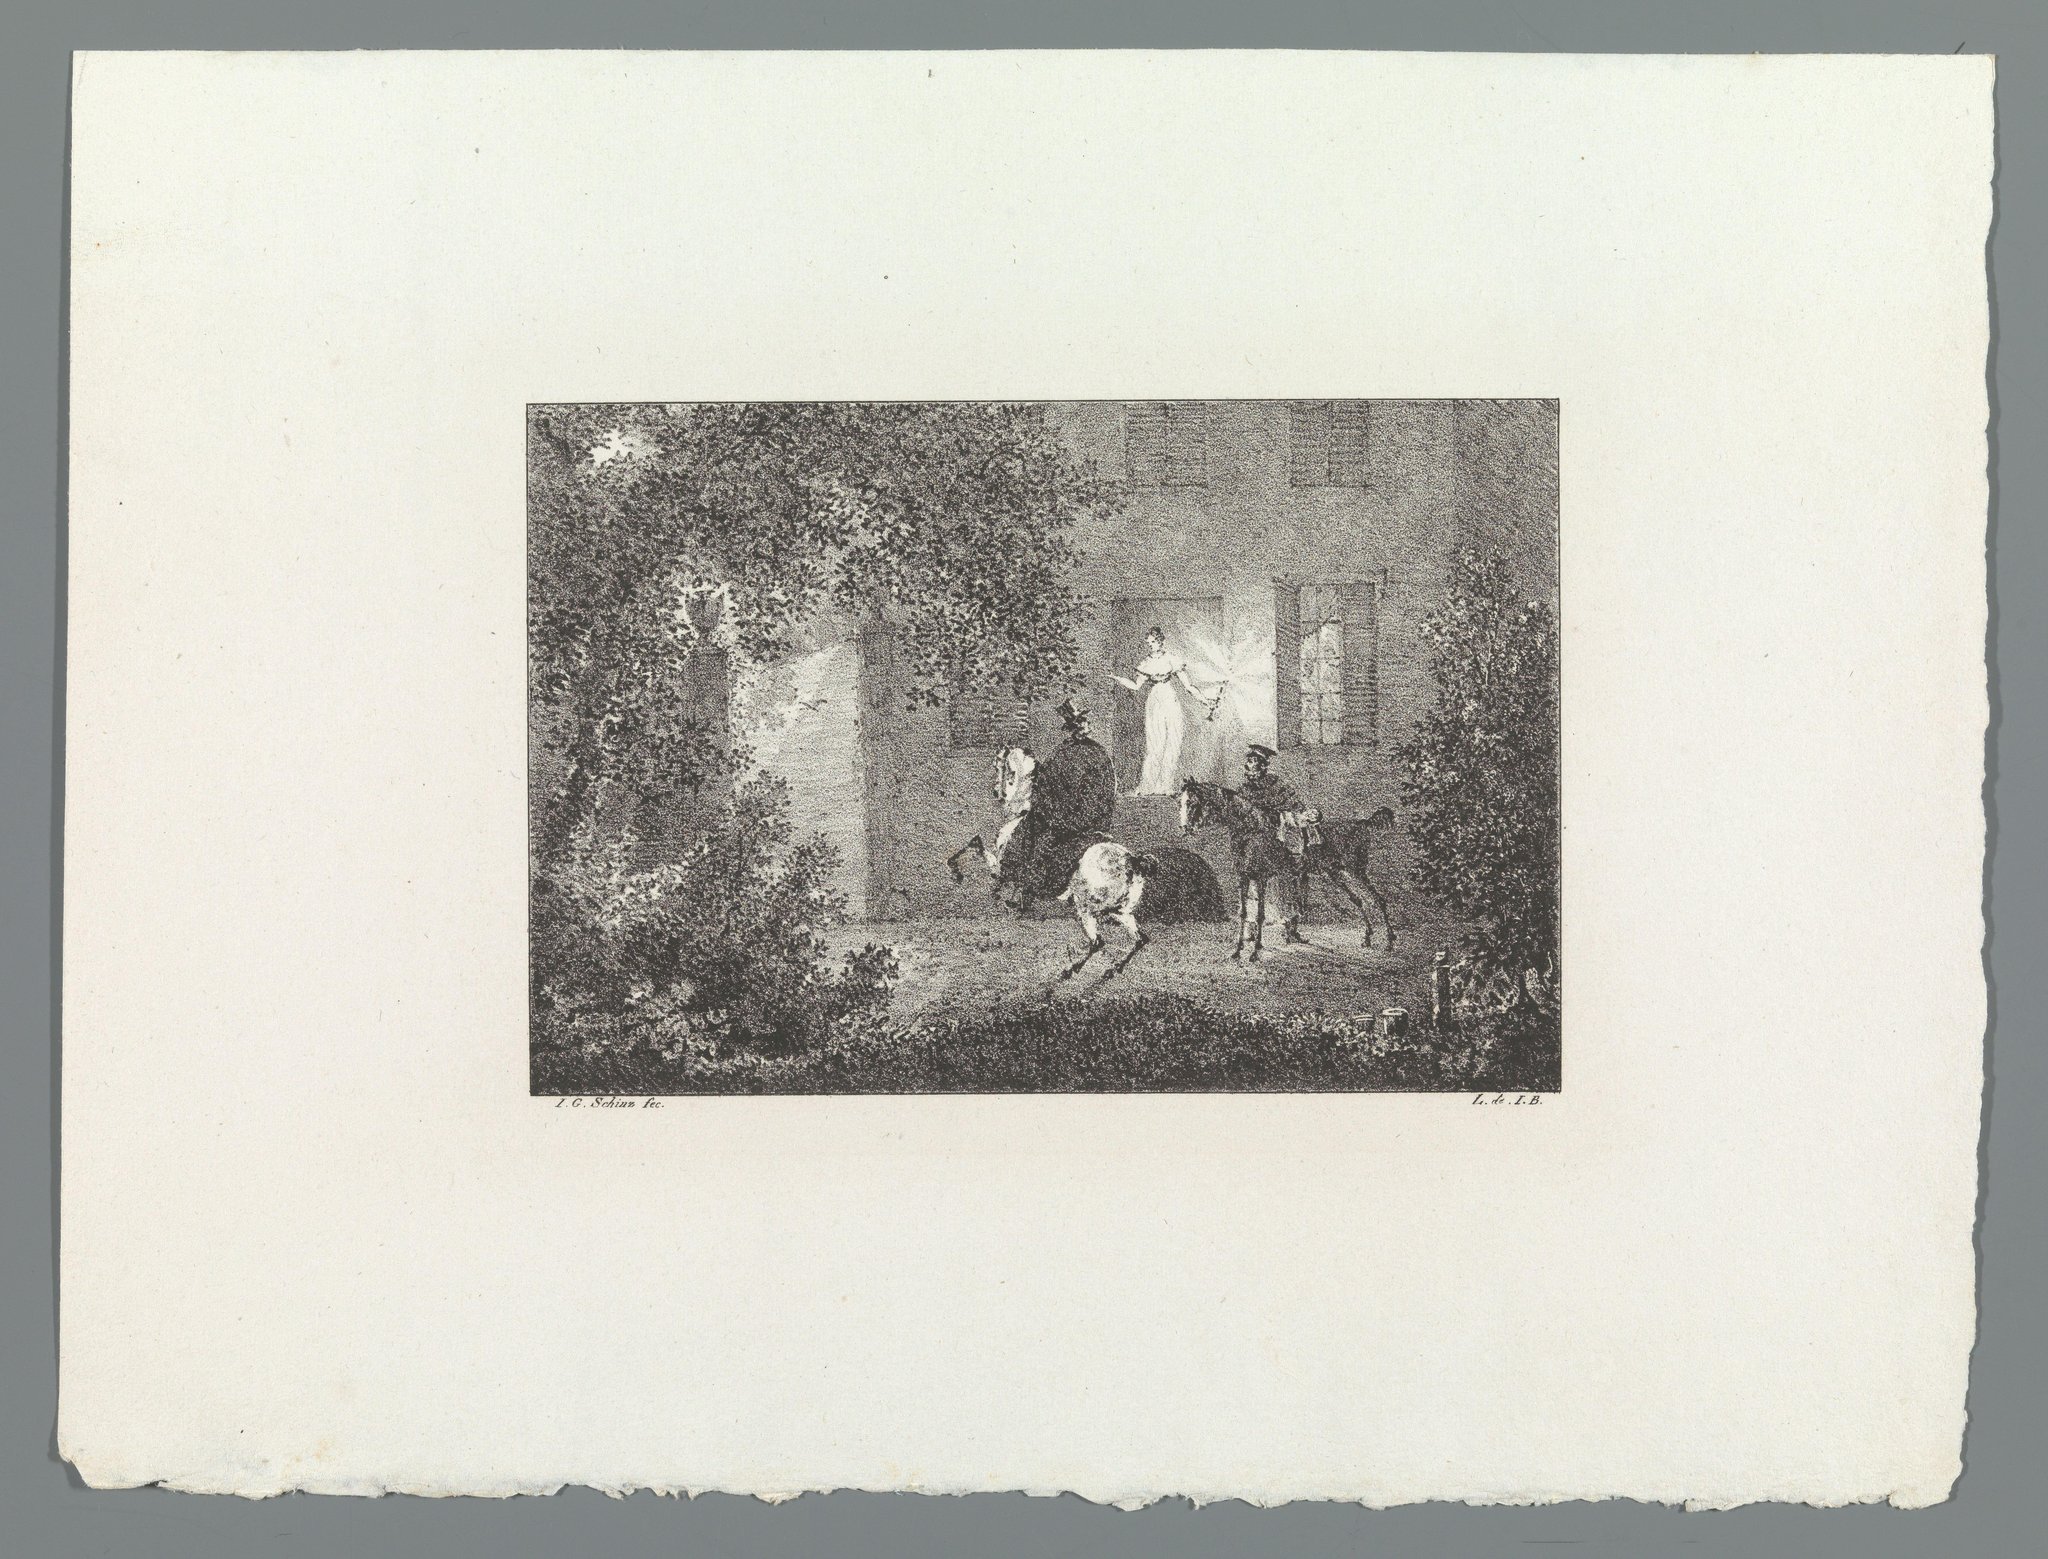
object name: print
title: Twee ruiters bij een jongedame in de deuropening: nachtscène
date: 1822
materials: paper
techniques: lithograph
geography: zurich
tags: riding a horse, ass, or mule; rider, horseman, night ~ landscape (sometimes titled 'nox')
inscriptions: collector's mark: Lugt 2228, collector's mark: ‘RA WANKLER’, collector's mark: Lugt 2760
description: Krijtlitho afkomstig uit de 'Lithographische Original-Zeichnungen von J.G. Schinz, Zürich 1822'